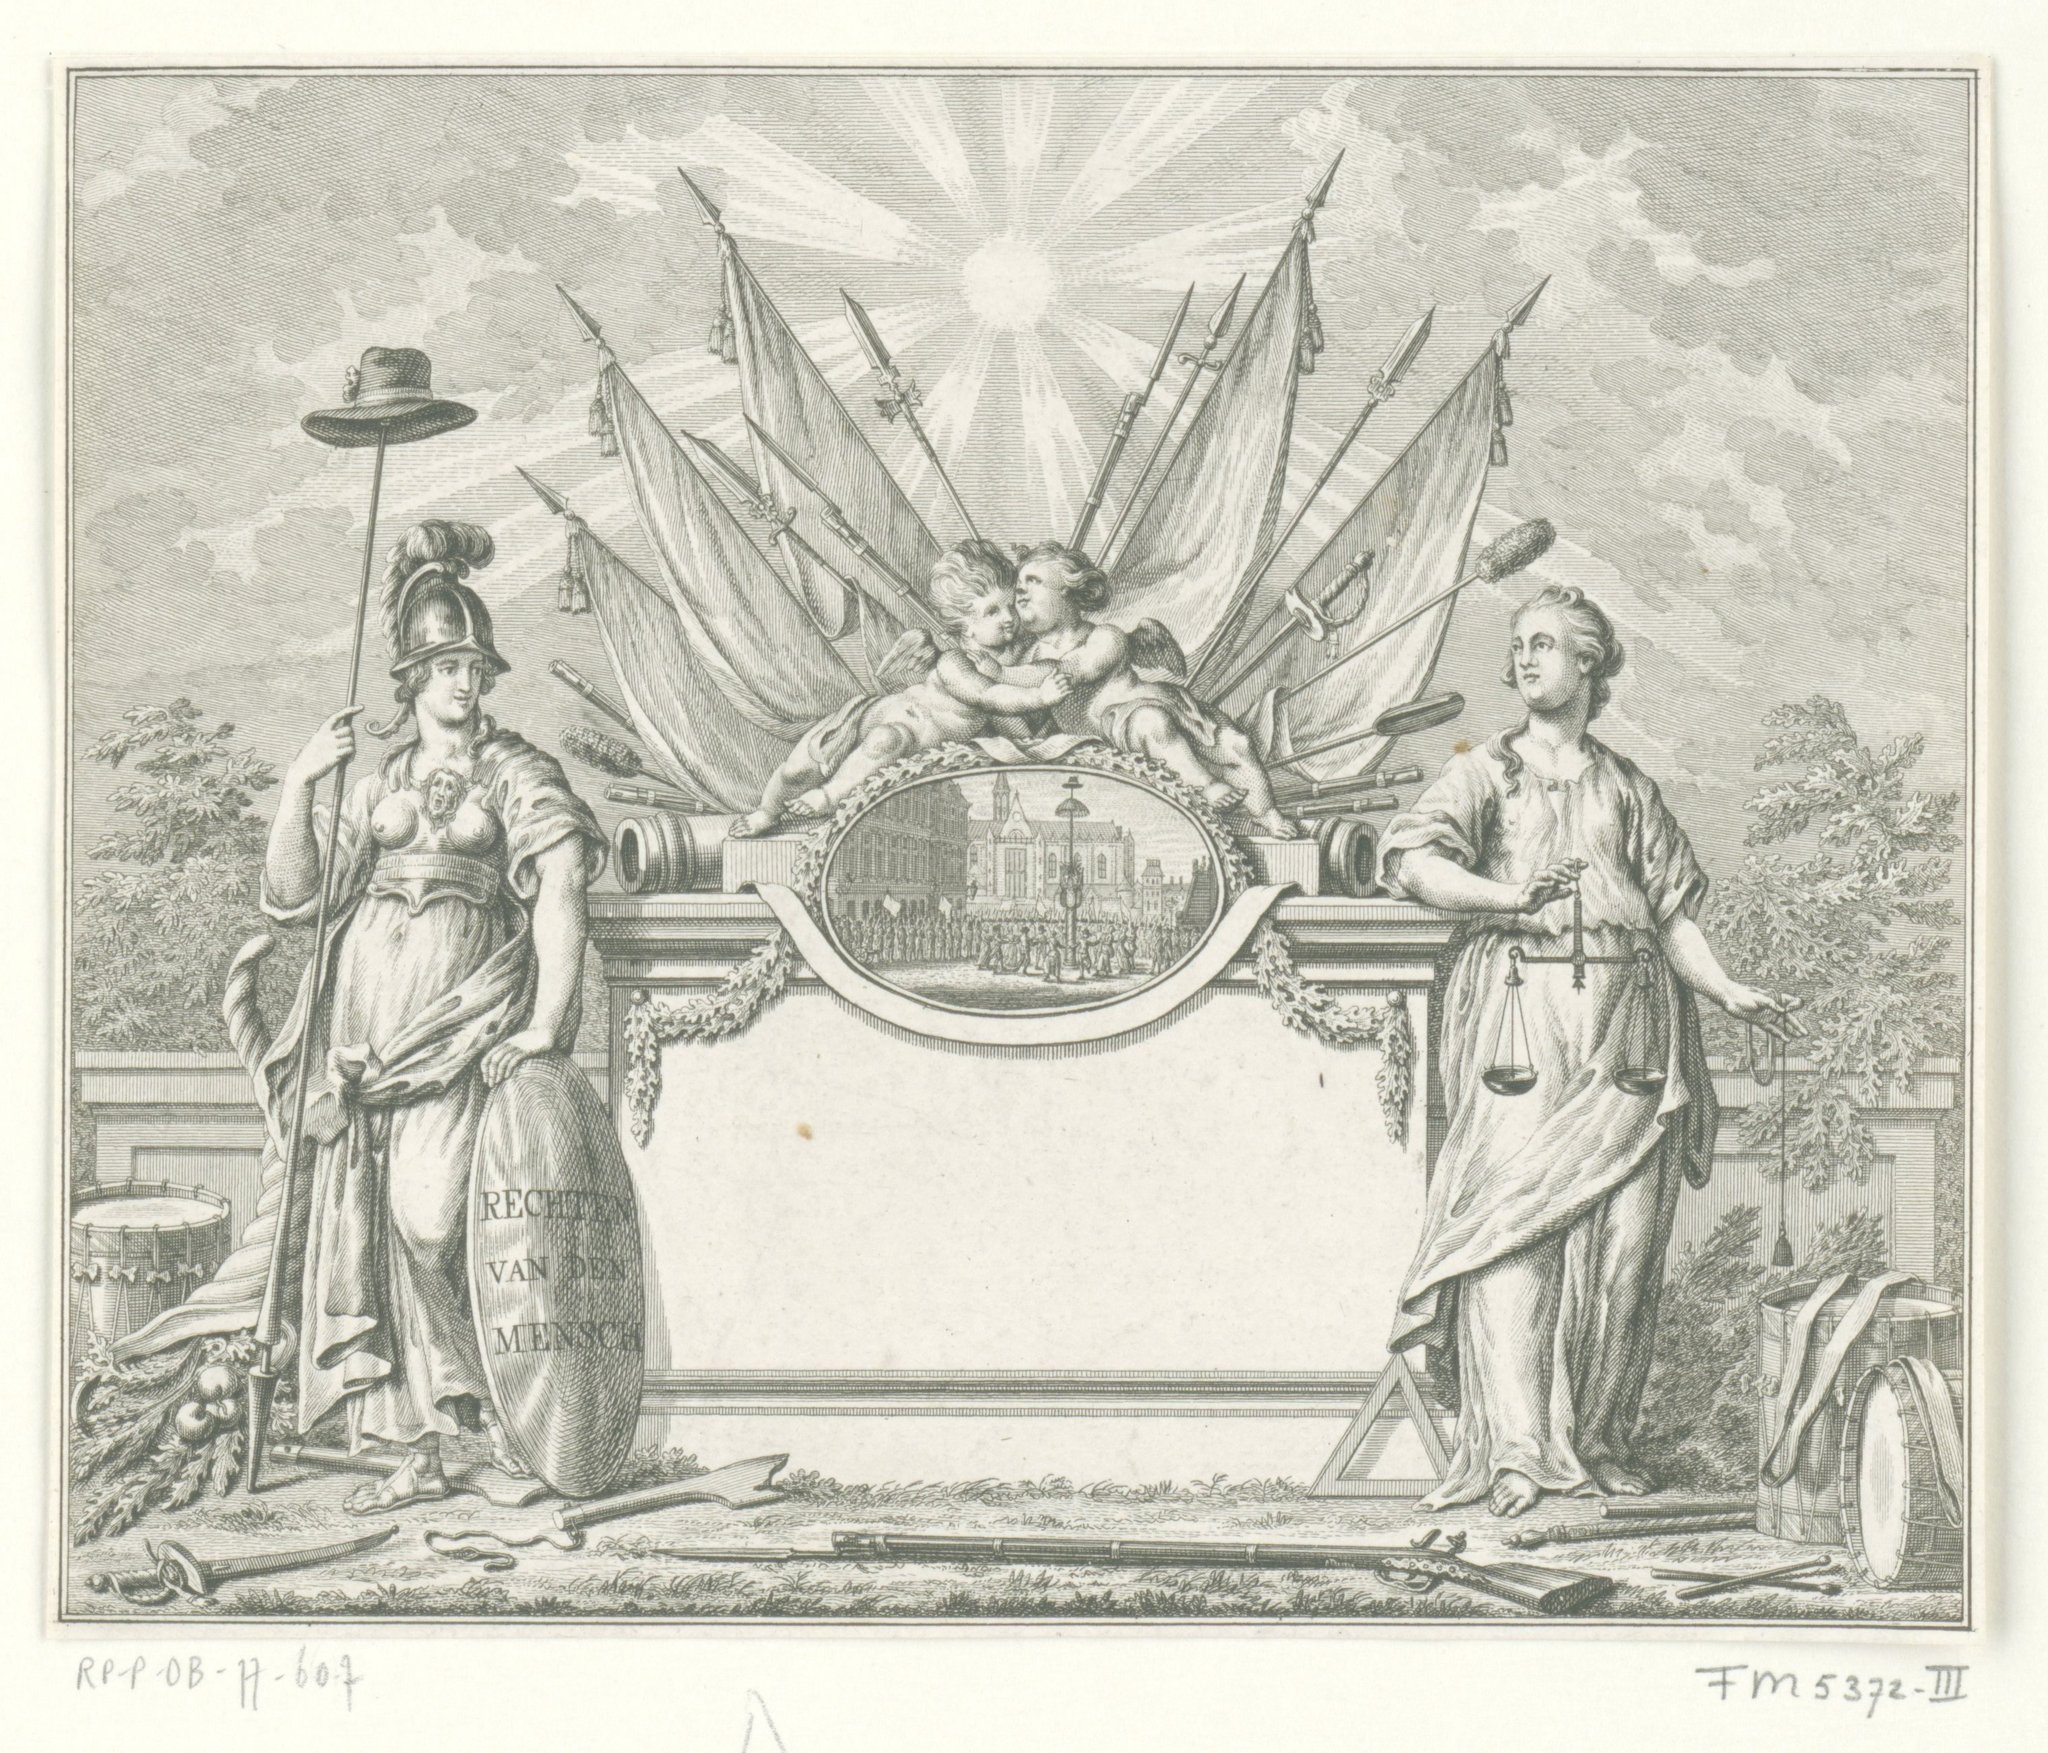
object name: print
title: Wijkbriefje van de Amsterdamse schutterij, 1795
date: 1795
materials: paper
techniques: engraving, etching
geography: netherlands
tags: equality, equity, fairness, righteousness; 'equalità', 'equità', 'giuditio giusto', 'ordine dritto e giusto', 'ugualità' (ripa) (+ abstract concept represented by female figure), freedom, liberty; 'libertà' (ripa) (+ abstract concept represented by female figure)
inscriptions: collector's mark: Lugt 2228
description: Oningevuld wijkbriefje of wachtbriefje van de Amsterdamse schutterij of ander lidmaatschapbewijs, 1795. Stenen voetstuk bekroond door een kleine voorstelling van het Amsterdamse vrijheidsfeest. Links de Vrijheid met een schild waarop 'Rechten van den Mensch', rechts Gelijkheid. Op de voorgrond liggen allerlei wapens.